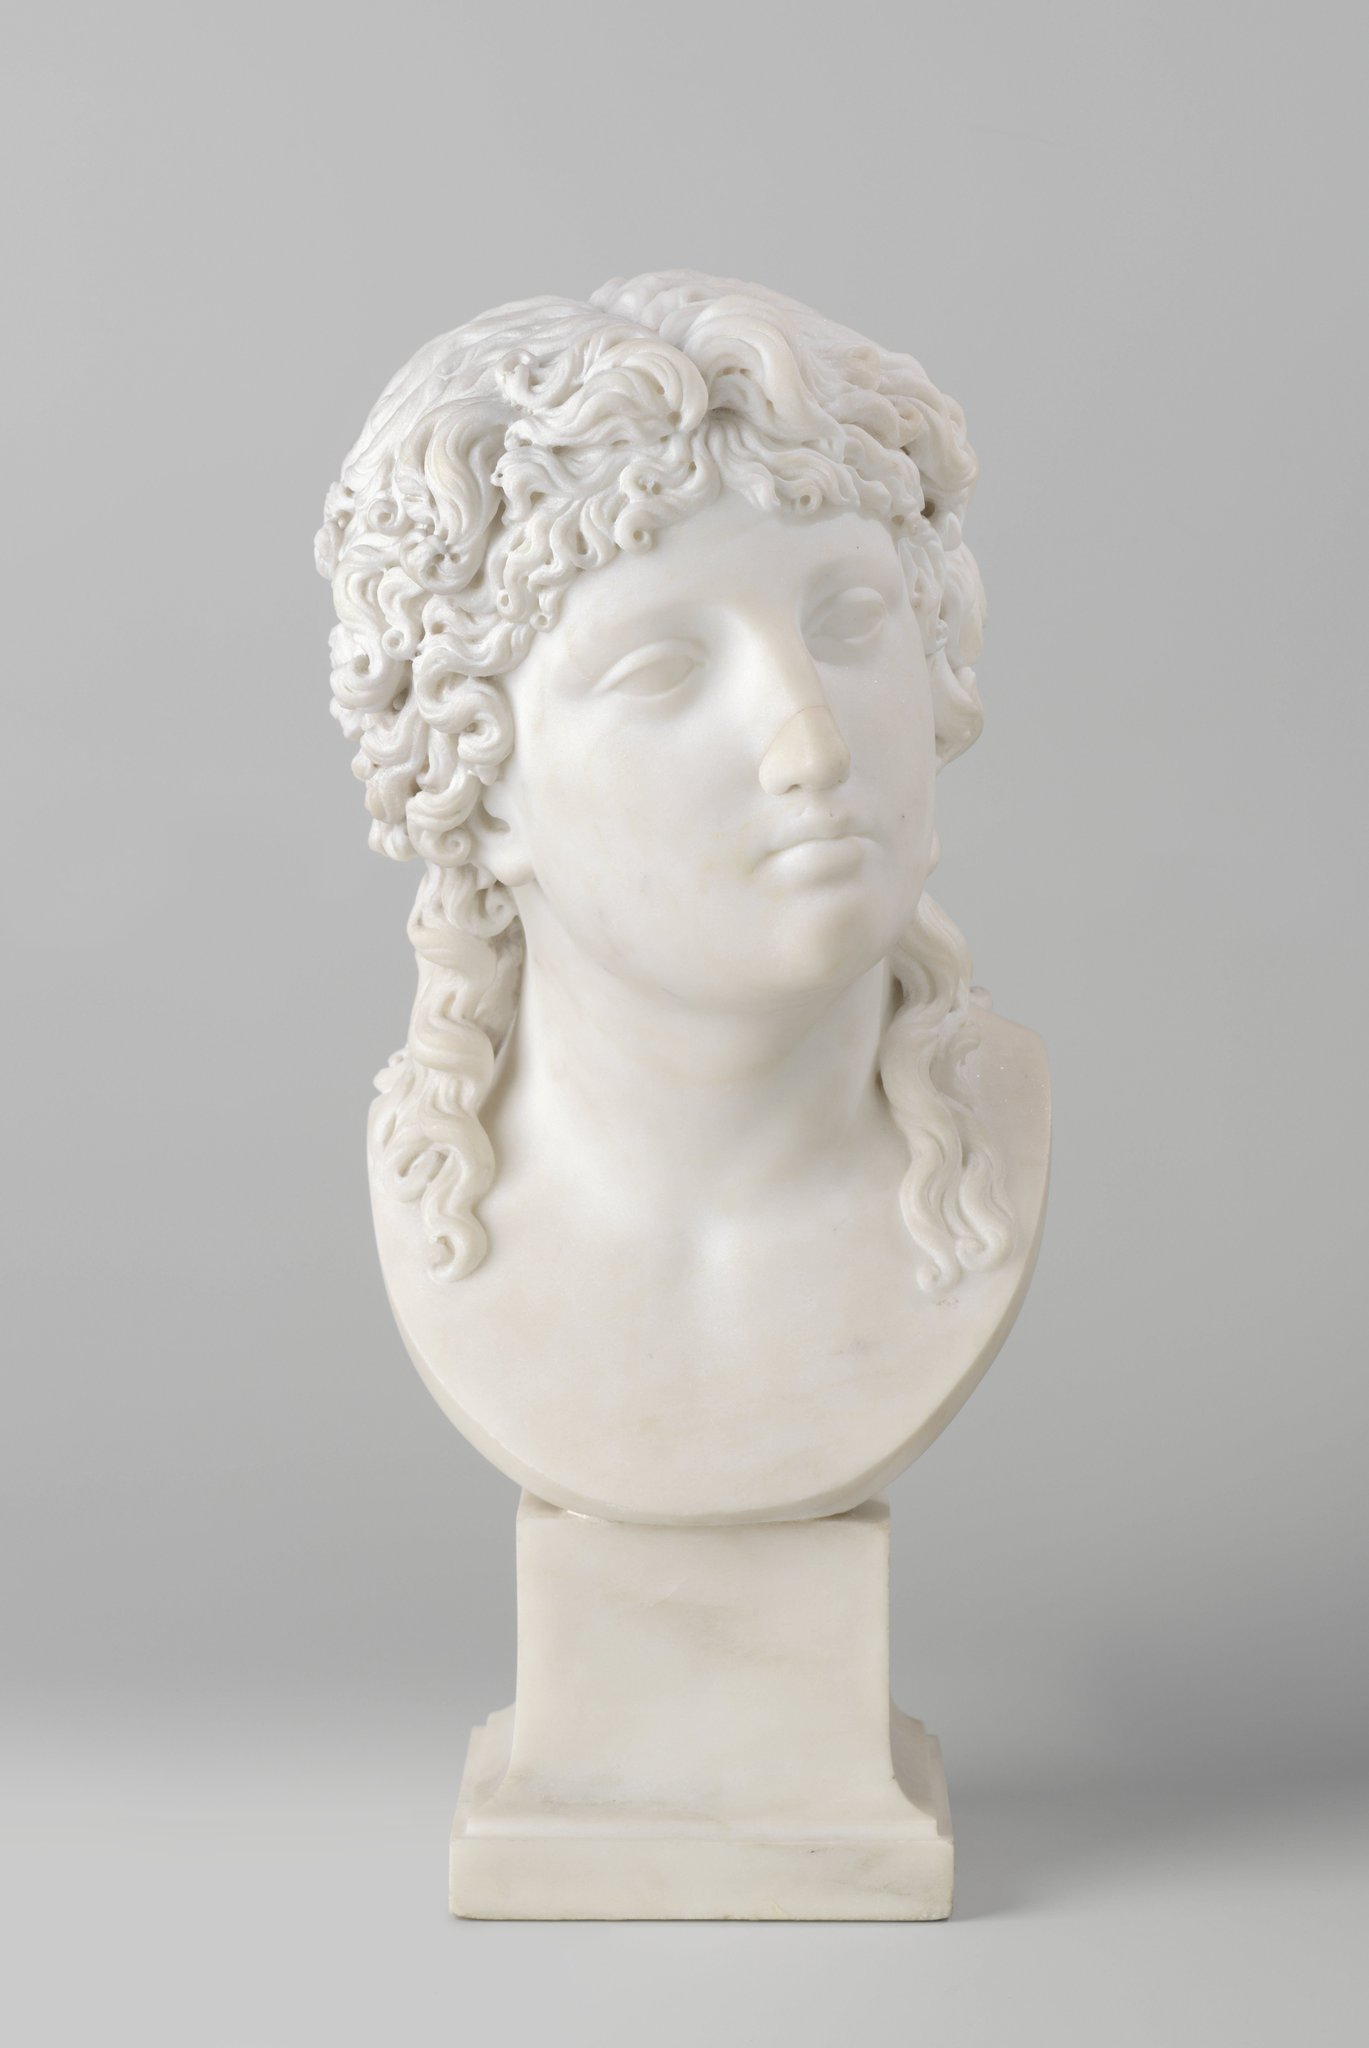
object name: sculpture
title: Borstbeeld van Apollo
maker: johann heinrich von dannecker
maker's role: draughtsman, sculptor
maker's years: 1758-1841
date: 1806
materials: marble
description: Johann Heinrich Dannecker (1758 - 1841). Apollo. Marble. Stuttgart, 1806. On loan from H.R.H. Princess Juliana of the Netherlands.